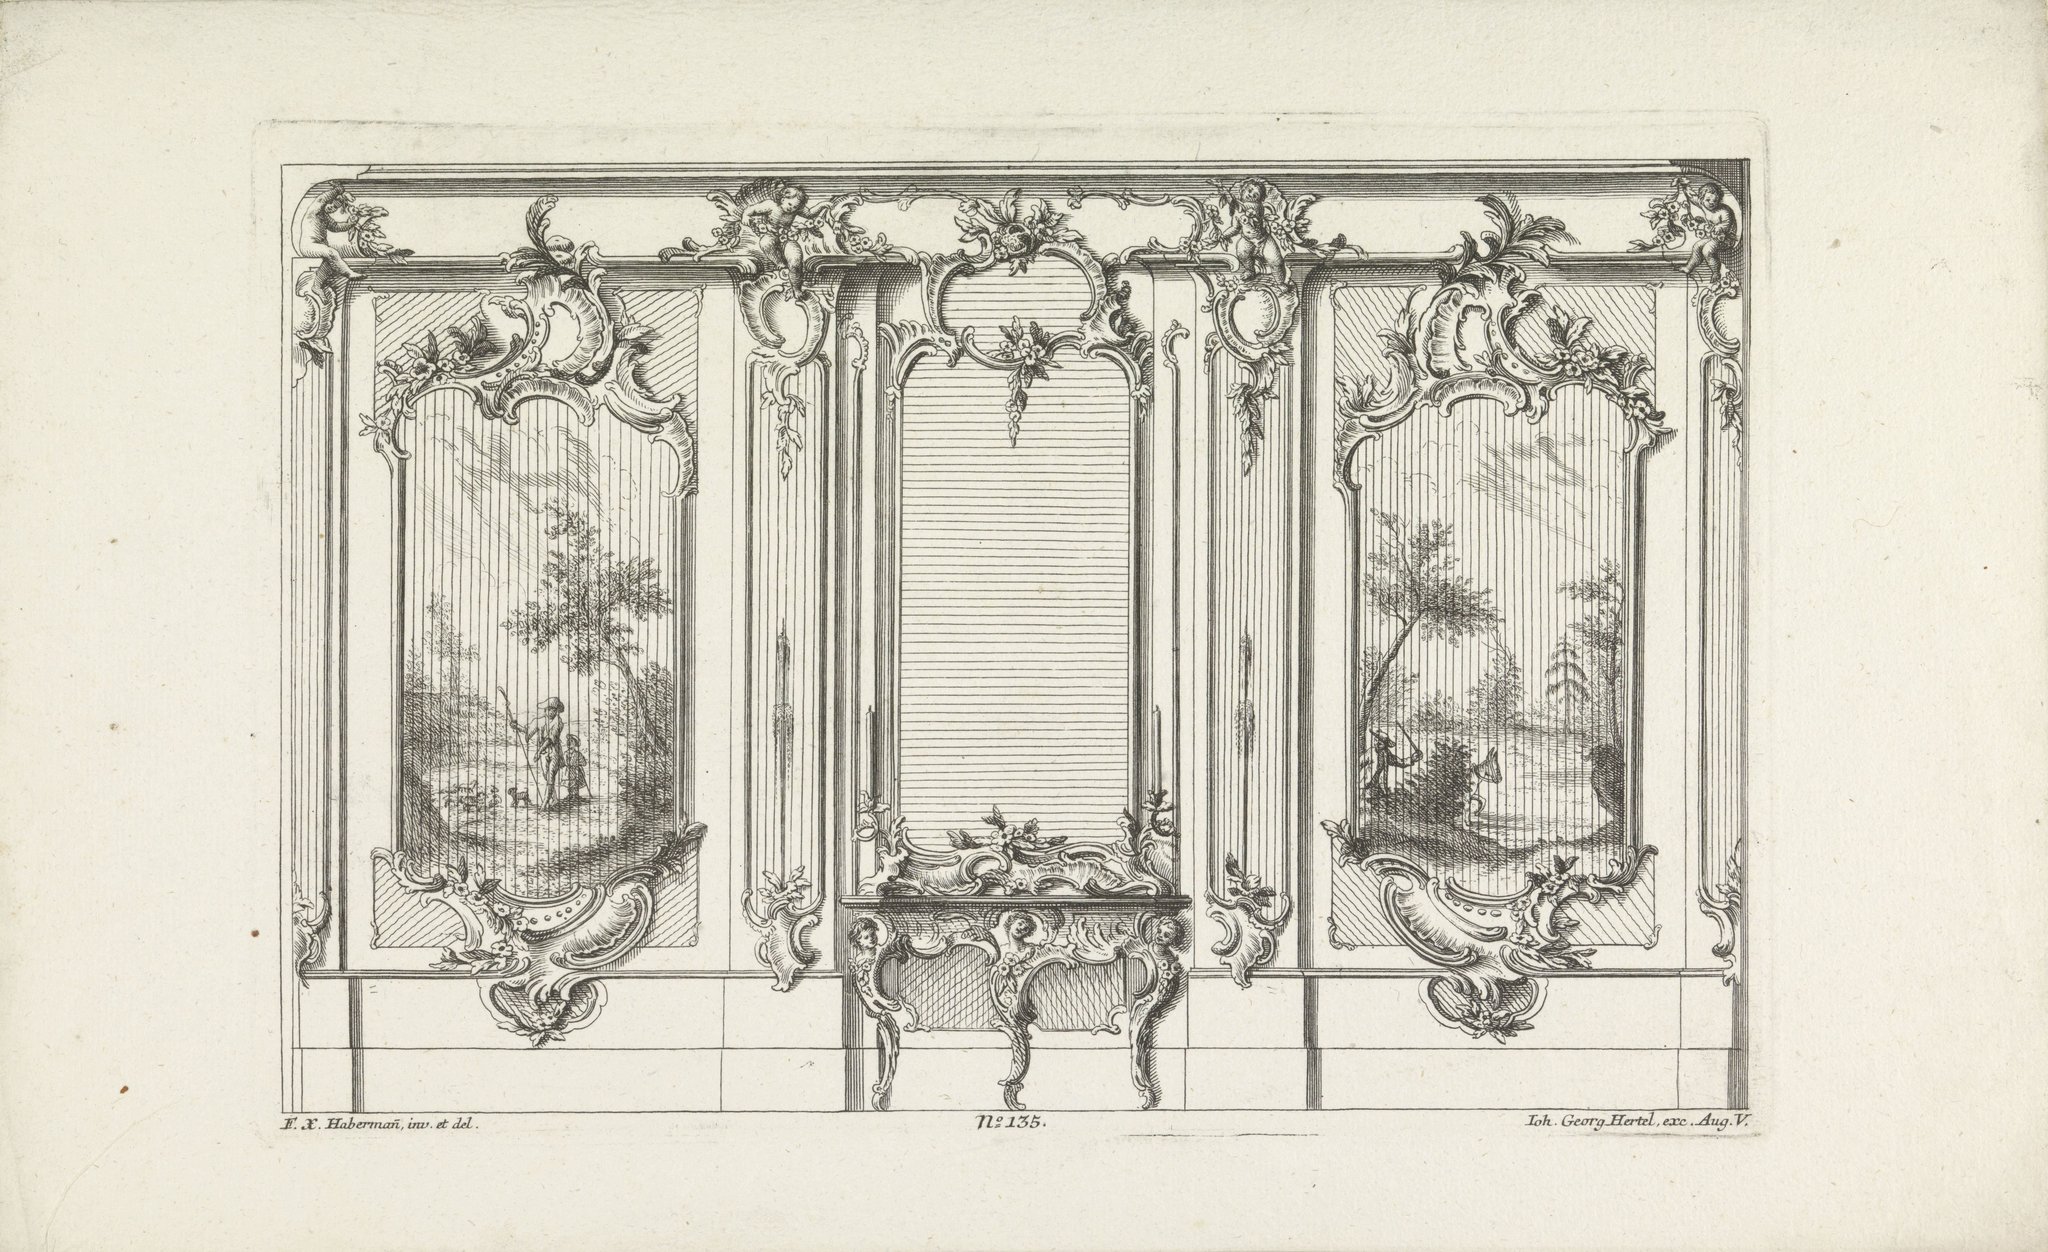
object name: print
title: Wandindeling met panelen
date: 1748-1753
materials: paper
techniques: engraving, etching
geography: augsburg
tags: rocaille ornament, panelling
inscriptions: collector's mark: Lugt 2760, collector's mark: Lugt 2228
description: Wandindeling met twee panelen met pastorale scènes, met rocaille omlijsting. Op de voorgrond een met rocailles versierde tafel. Uitgeversnummer 135.